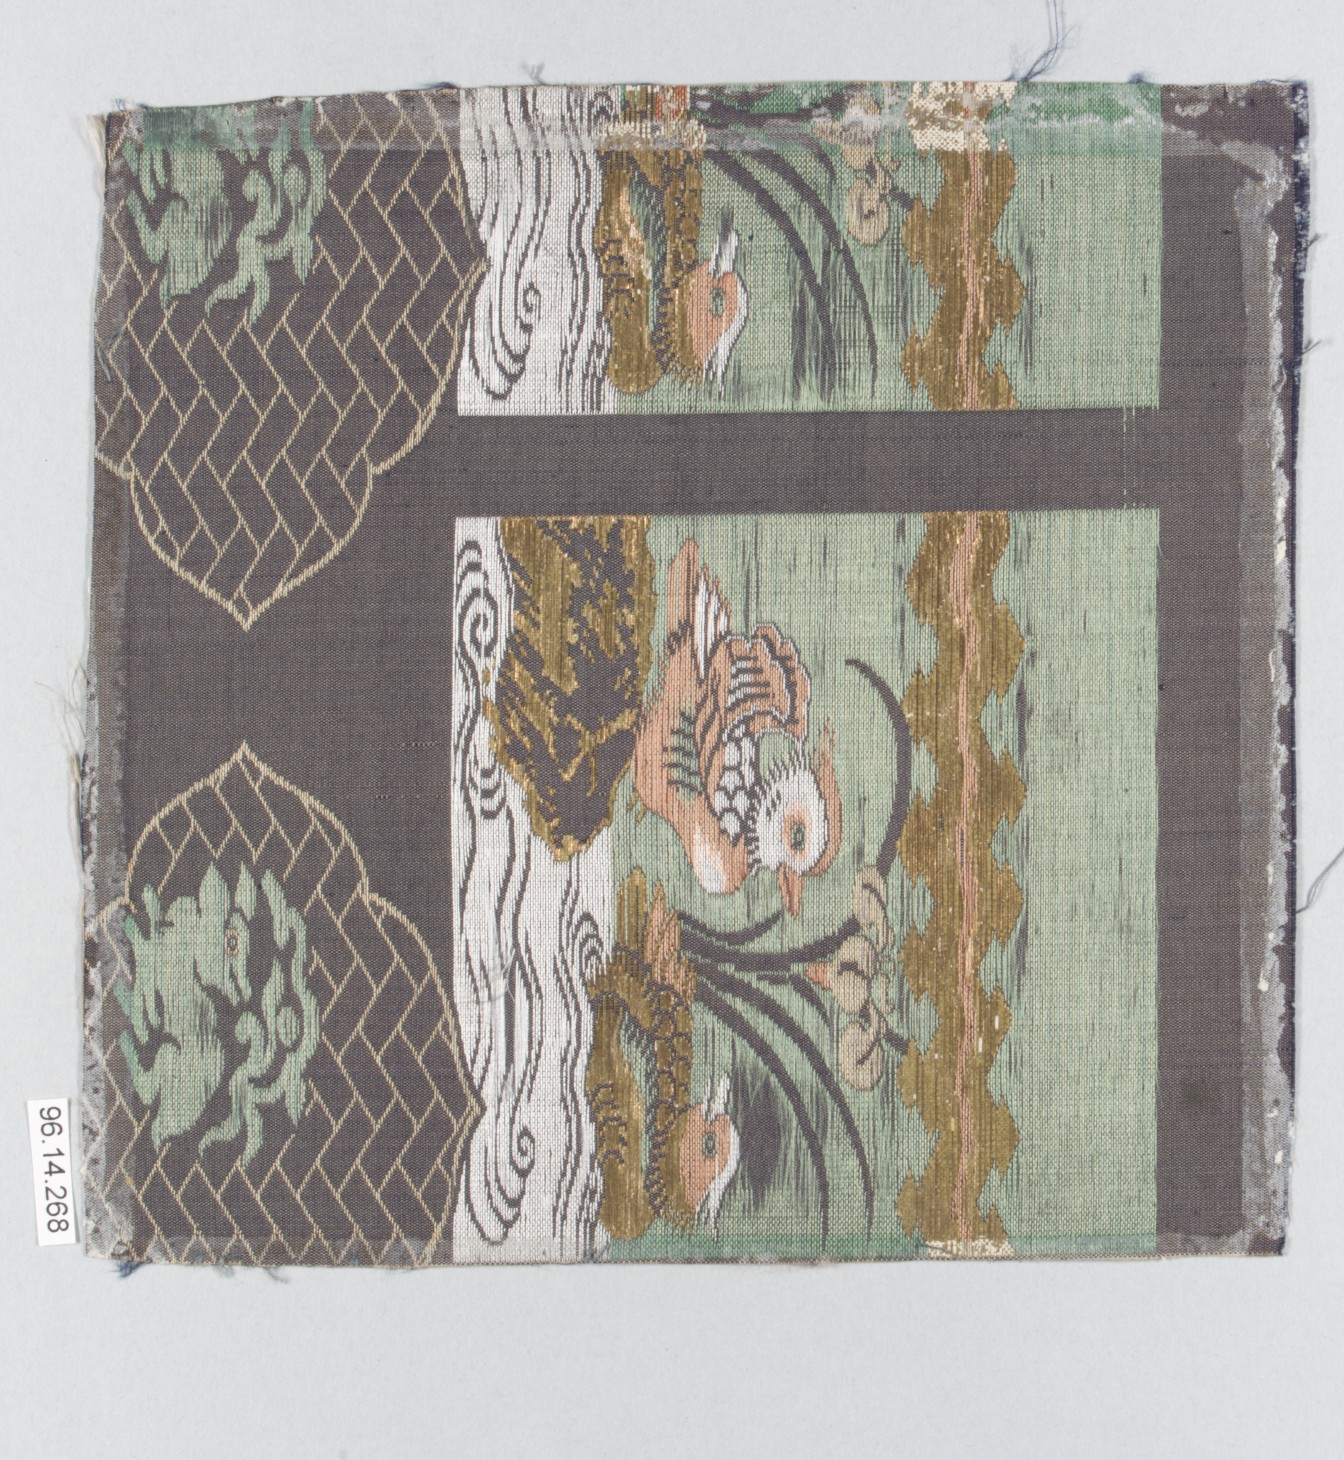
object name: piece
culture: japanese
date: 1801-1900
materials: metal thread, silk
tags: ducks,rabbits,orchids